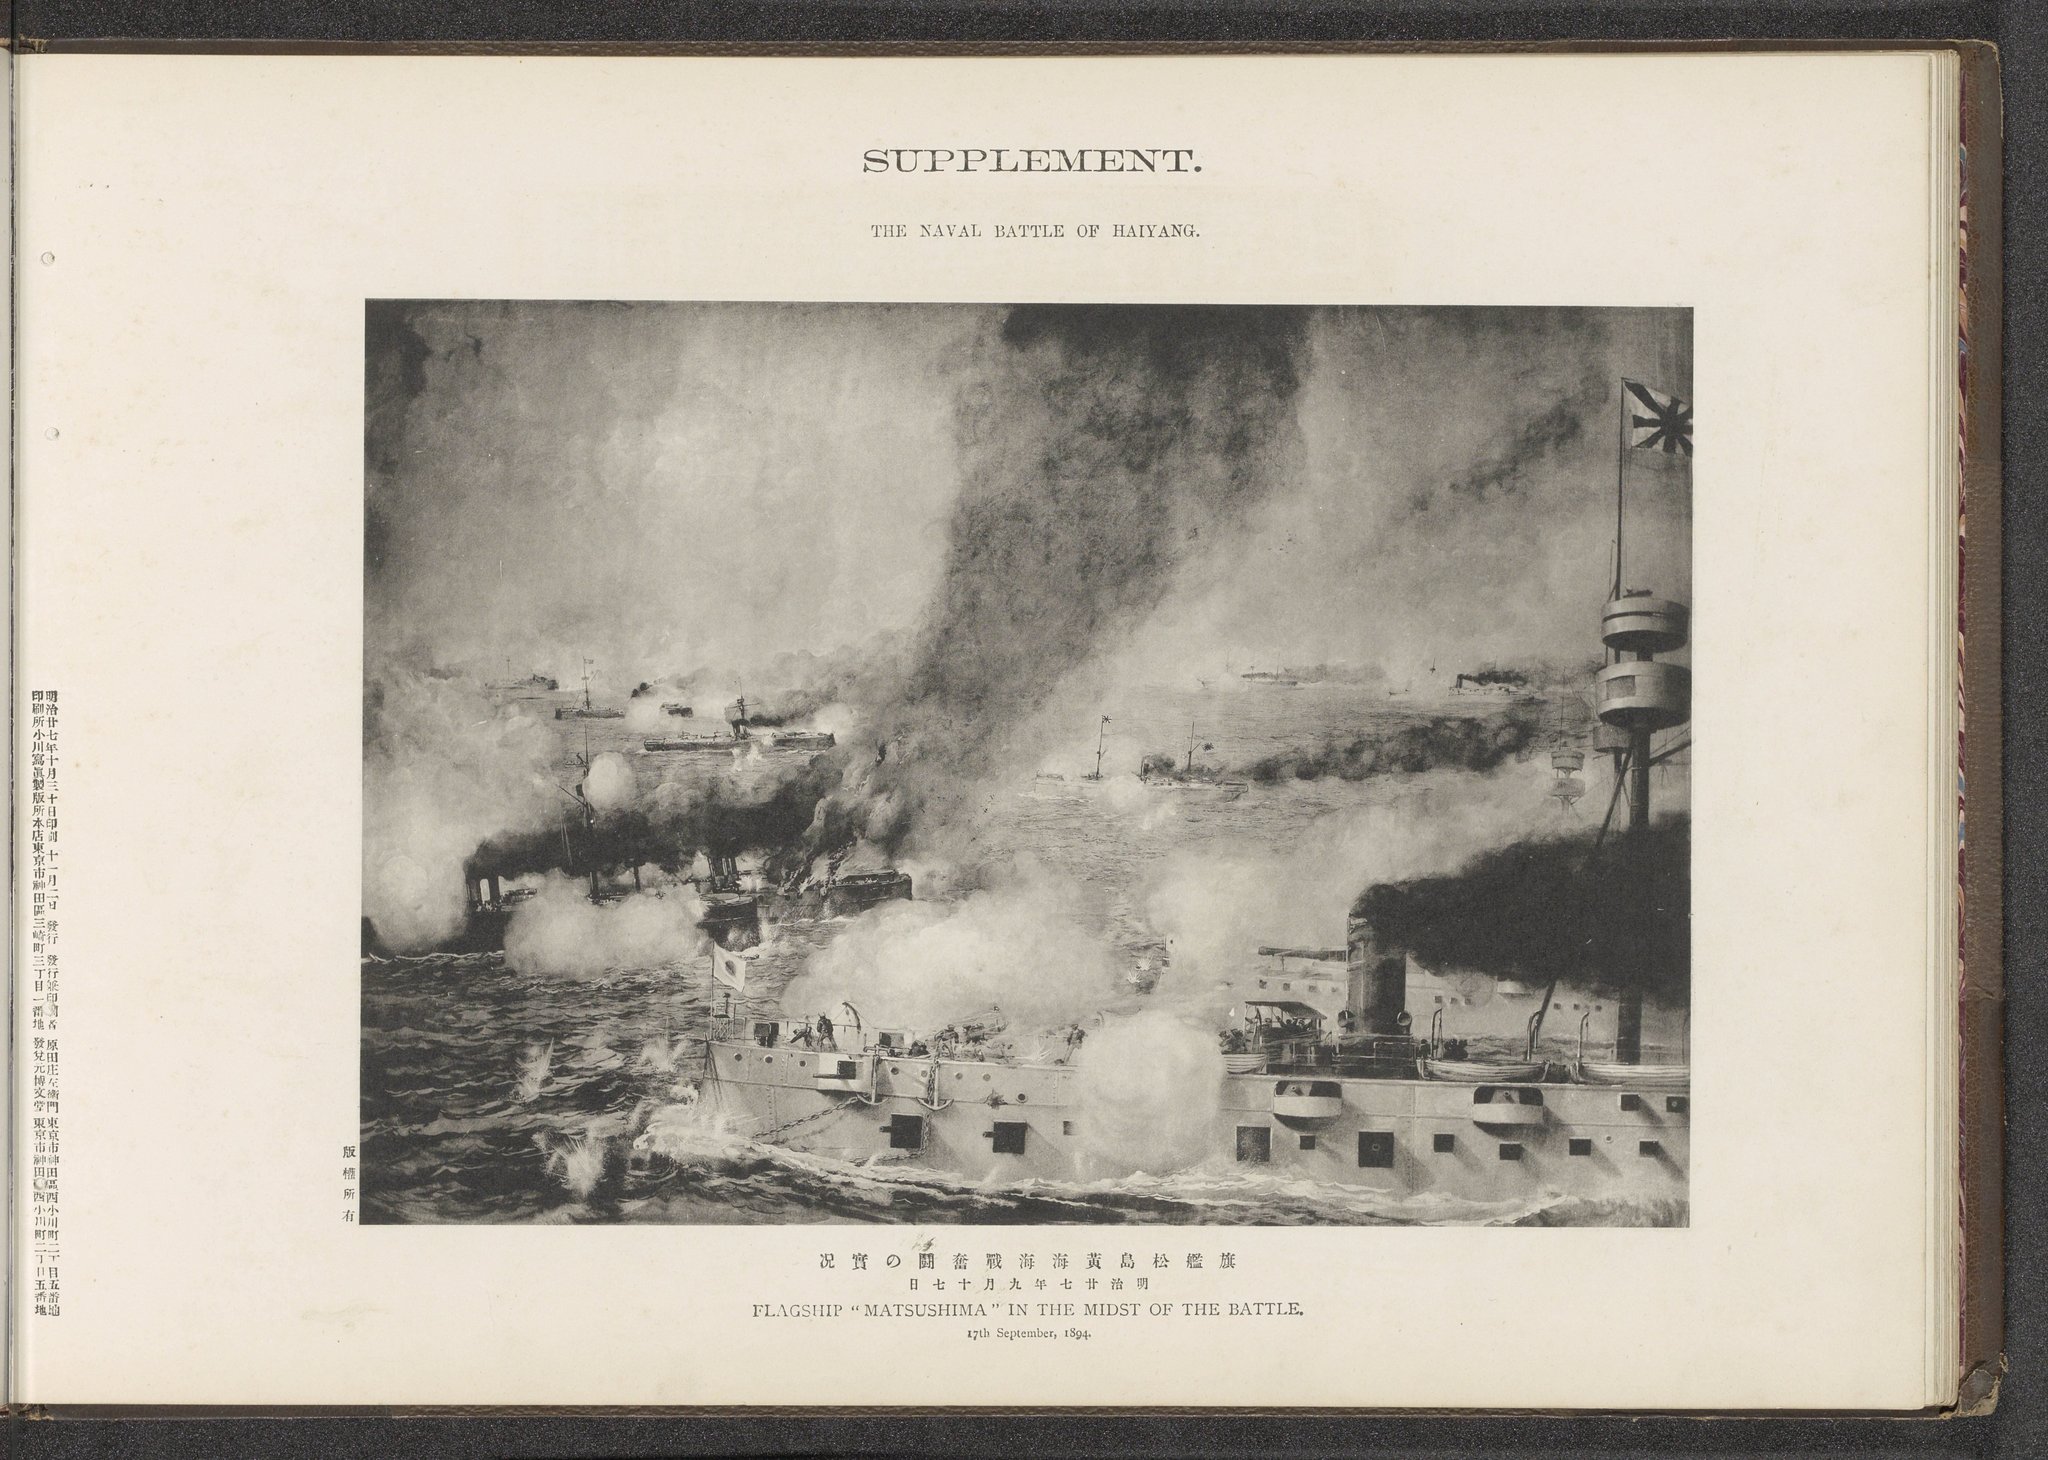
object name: photomechanical print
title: Flagship "Matsushima" in the midst of the battle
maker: kazumasa ogawa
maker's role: auteur, fotograaf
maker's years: 1860-1929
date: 1894-1895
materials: paper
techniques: photograph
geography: japan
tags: battle, ships (in general)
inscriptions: inscription: ‘The naval battle of Haiyang.’